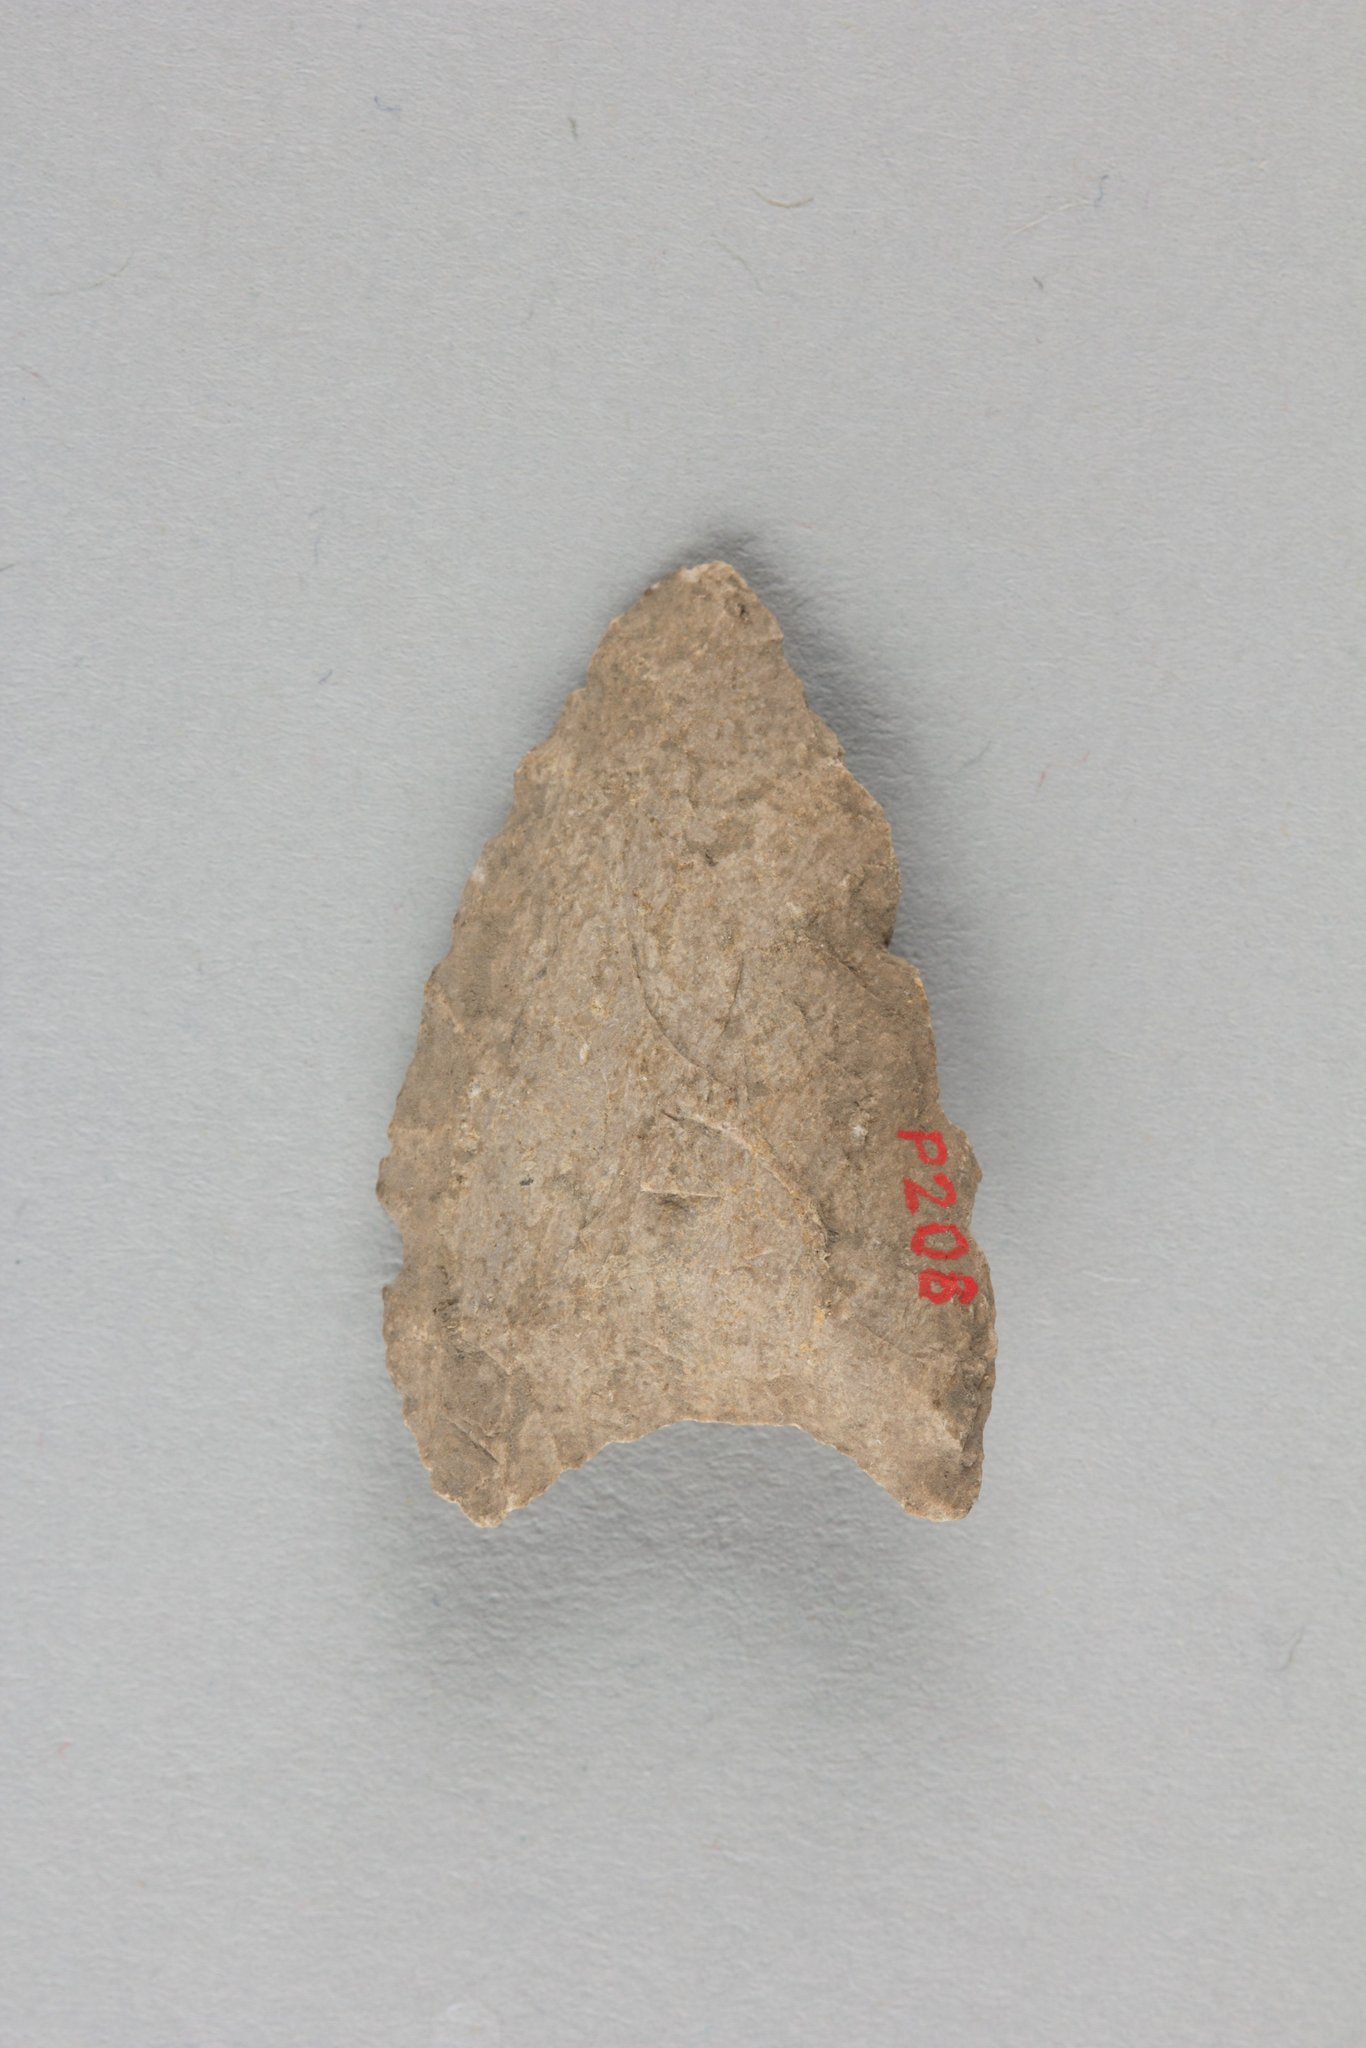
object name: arrowhead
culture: japanese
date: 1500-1000 BCE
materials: stone